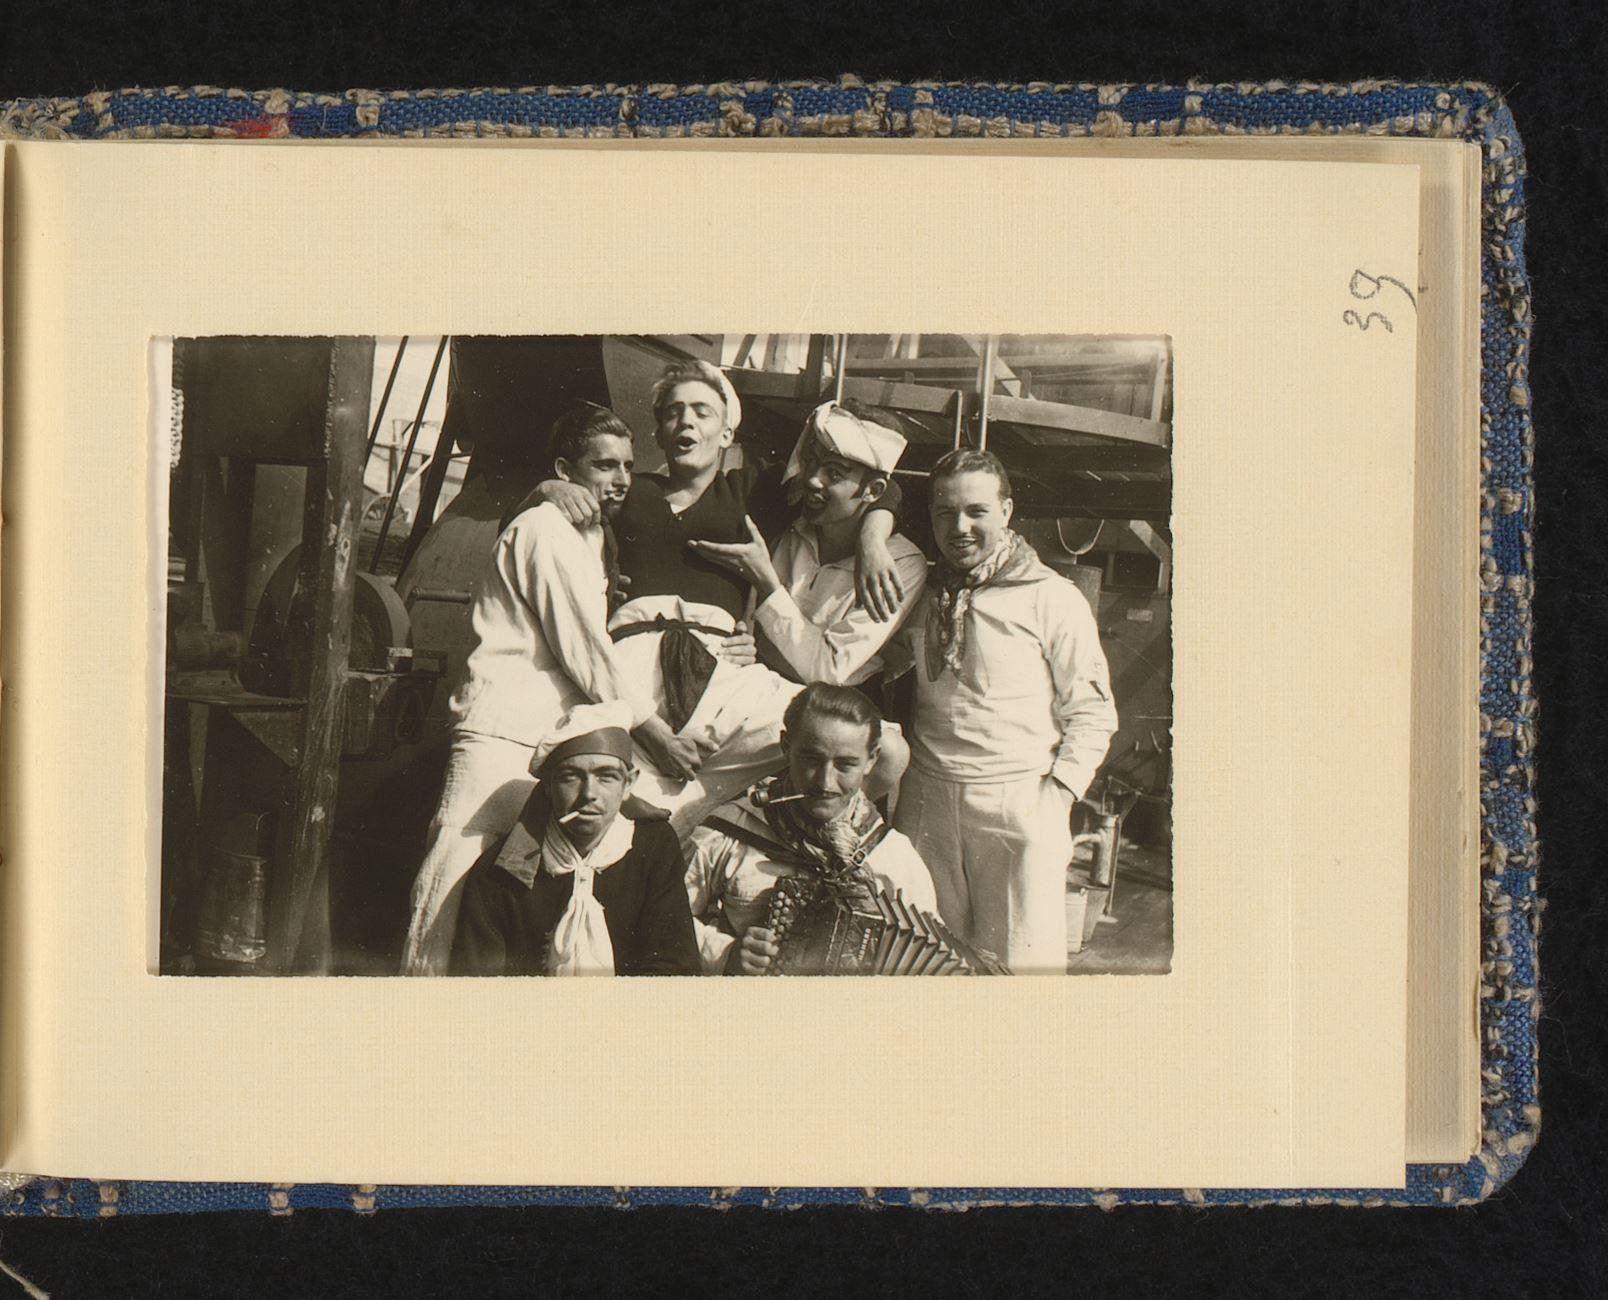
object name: photograph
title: Matrozen met een accordeon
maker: Anonymous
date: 1940-1943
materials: photographic support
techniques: gelatin silver print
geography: france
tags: the company, the unit, the troop ~ military service, accordion - cc - out of doors, sailor, france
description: Groep Duitse matrozen aan boord van het schip maken plezier met een accordeon, sommigen zijn geschminkt. Onderdeel van het fotoalbum over de Kriegsmarine 1940-1943.